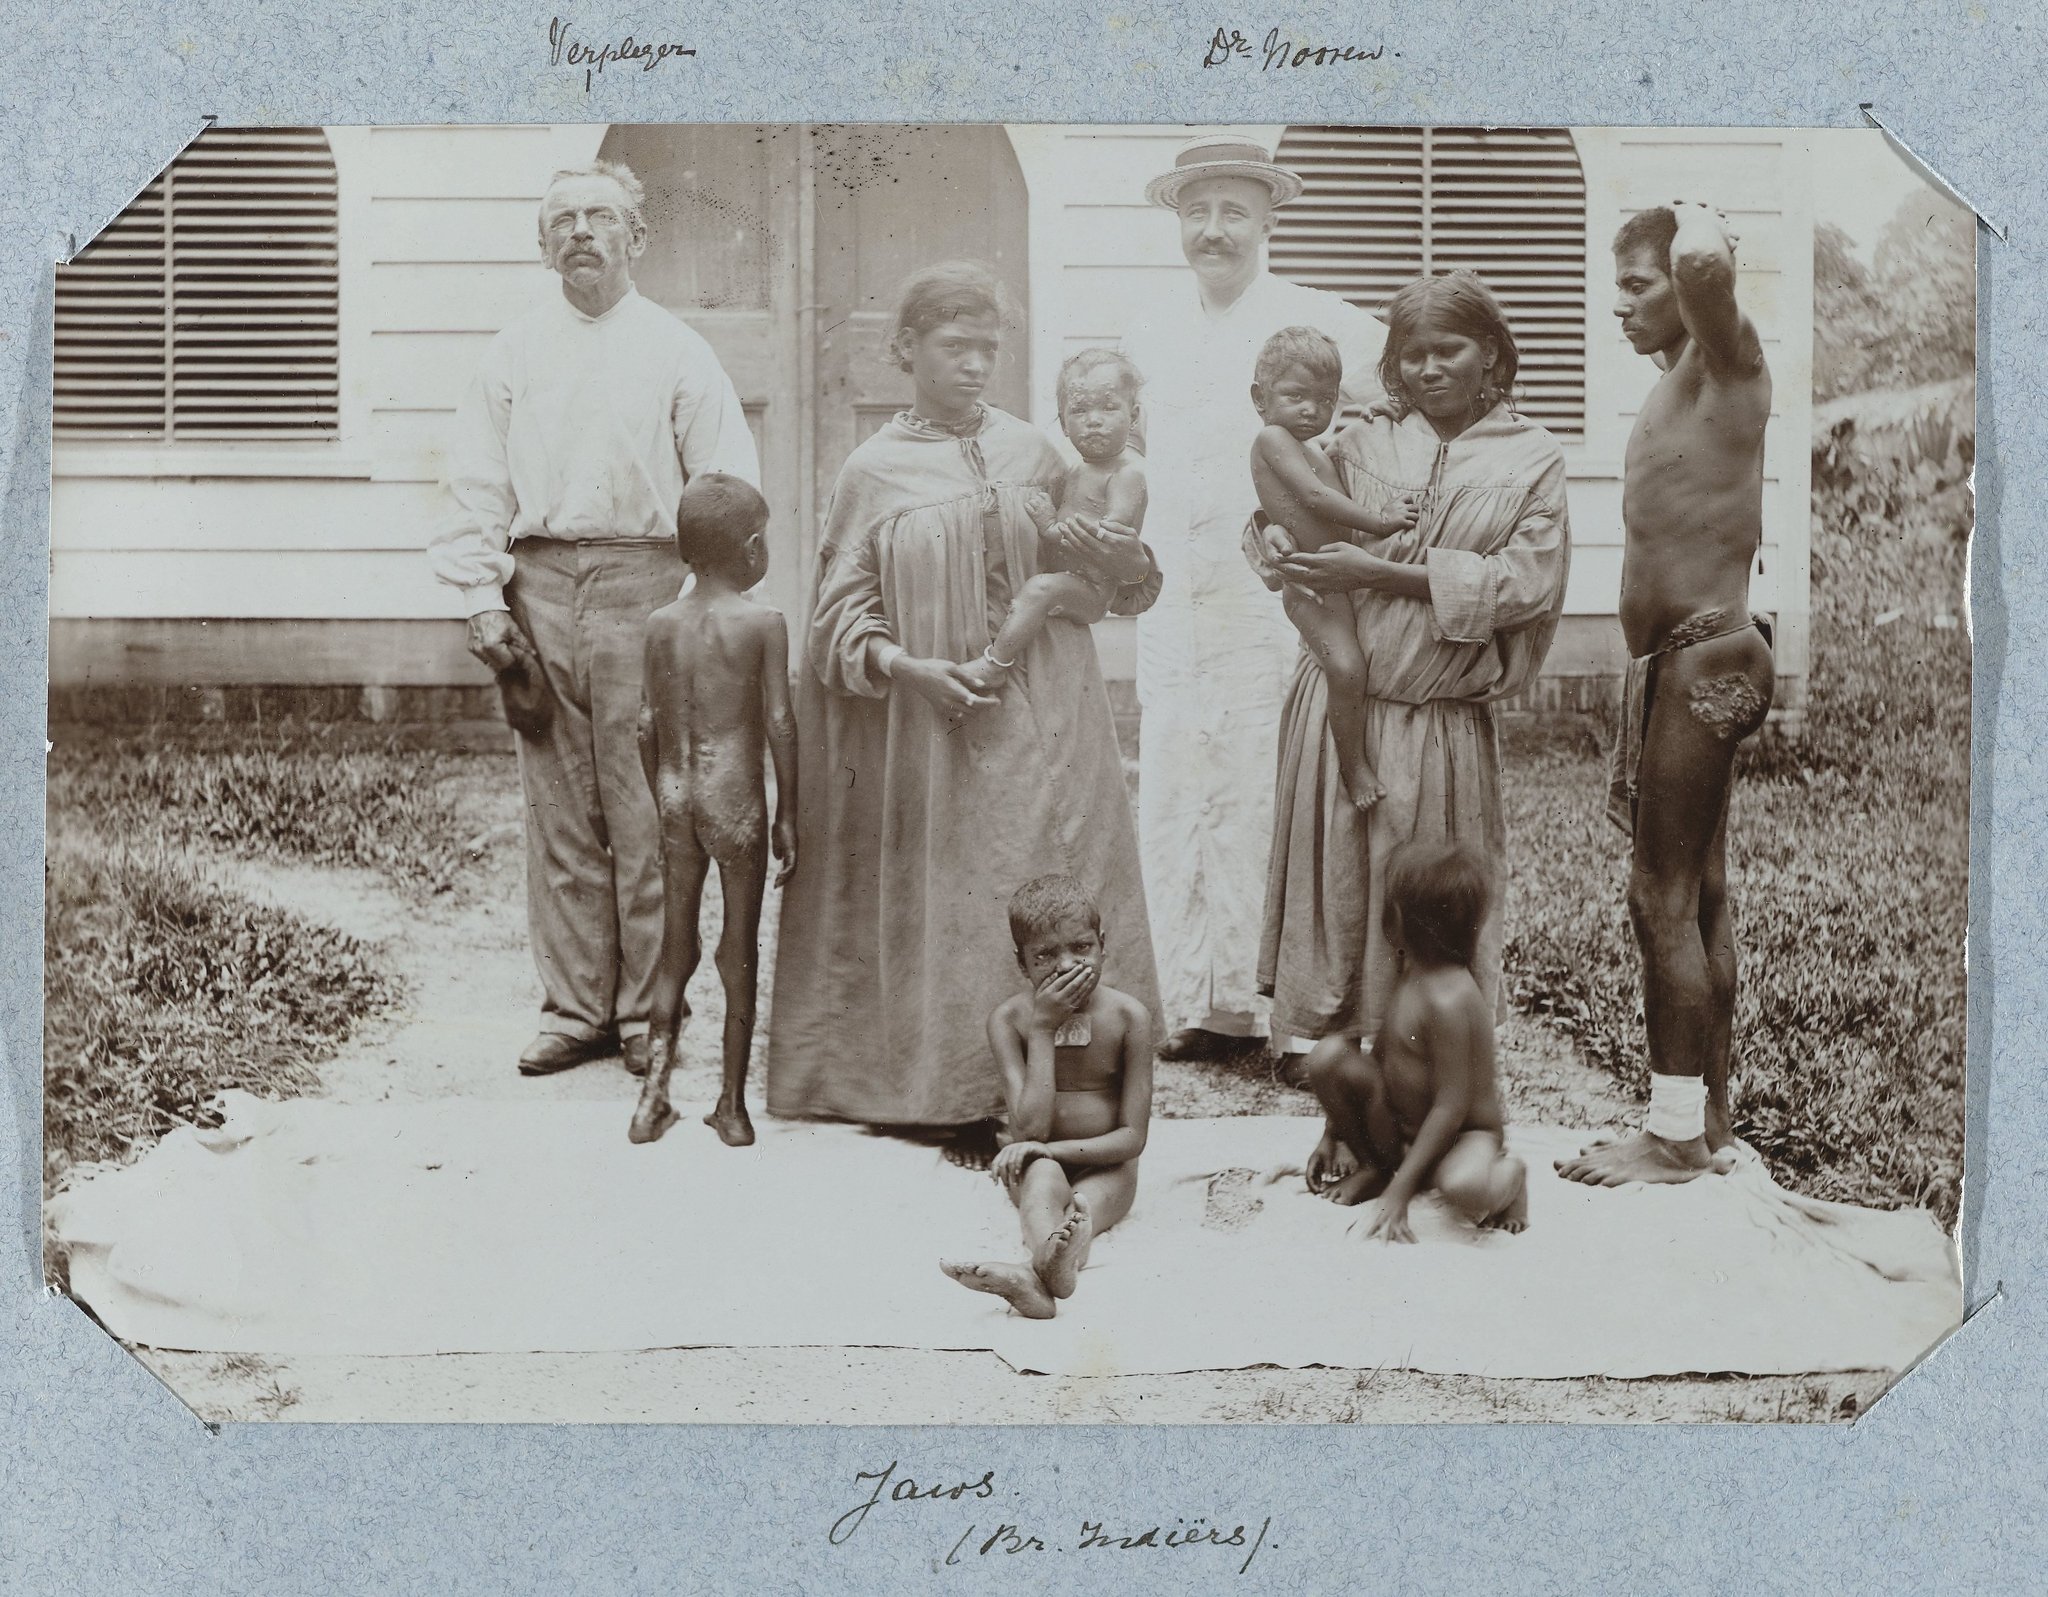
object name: photograph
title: Photographs of Paramaribo and Maroon Village on the Saramacca River, Suriname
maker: théodore van lelyveld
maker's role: painter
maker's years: 1867-1954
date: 1895-1898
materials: photographic support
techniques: collodion silver print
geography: suriname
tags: patient, sick person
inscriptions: inscription: ‘Jaios (Br. Indiërs) / Verpleger / Dr. Nooren’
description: Van Lelyveld left for Suriname as a 28-year old to work as the assistant to the Dutch governor Titus van Asch van Wijck. This presented him with every opportunity to photograph all of the layers of the Surinamese society in the farthest nooks and crannies. Like a seasoned photojournalist he recorded all of the districts of Paramaribo, celebrations on queen’s birthday, population groups and the work camps of the Javanese contract labourers.